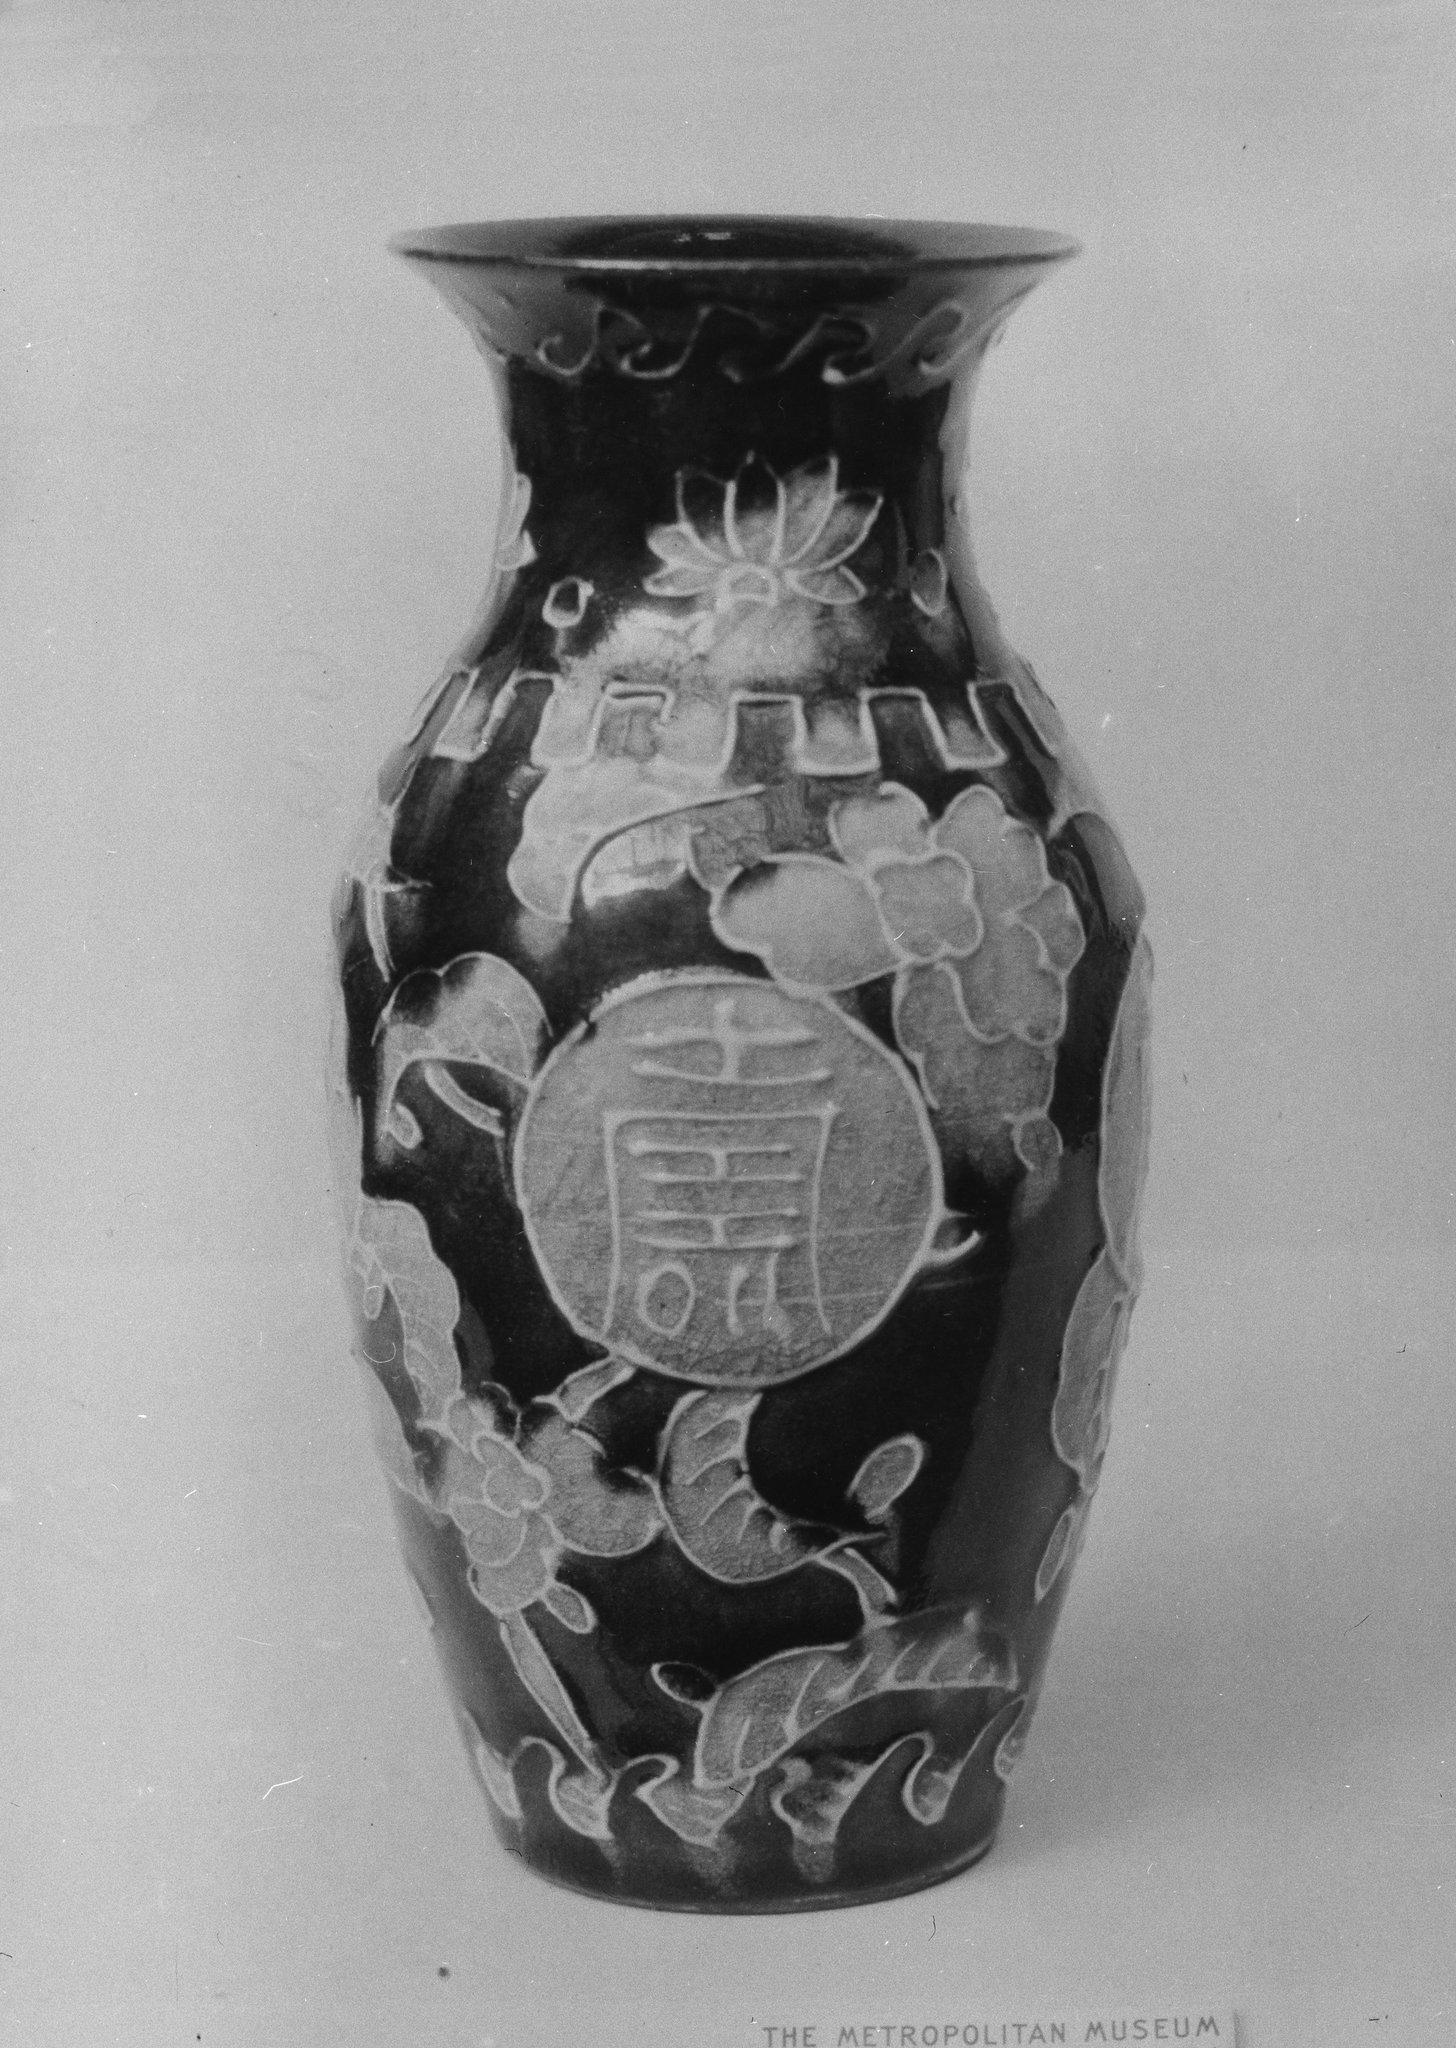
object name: vase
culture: japanese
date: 1830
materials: glaze, stoneware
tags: flowers